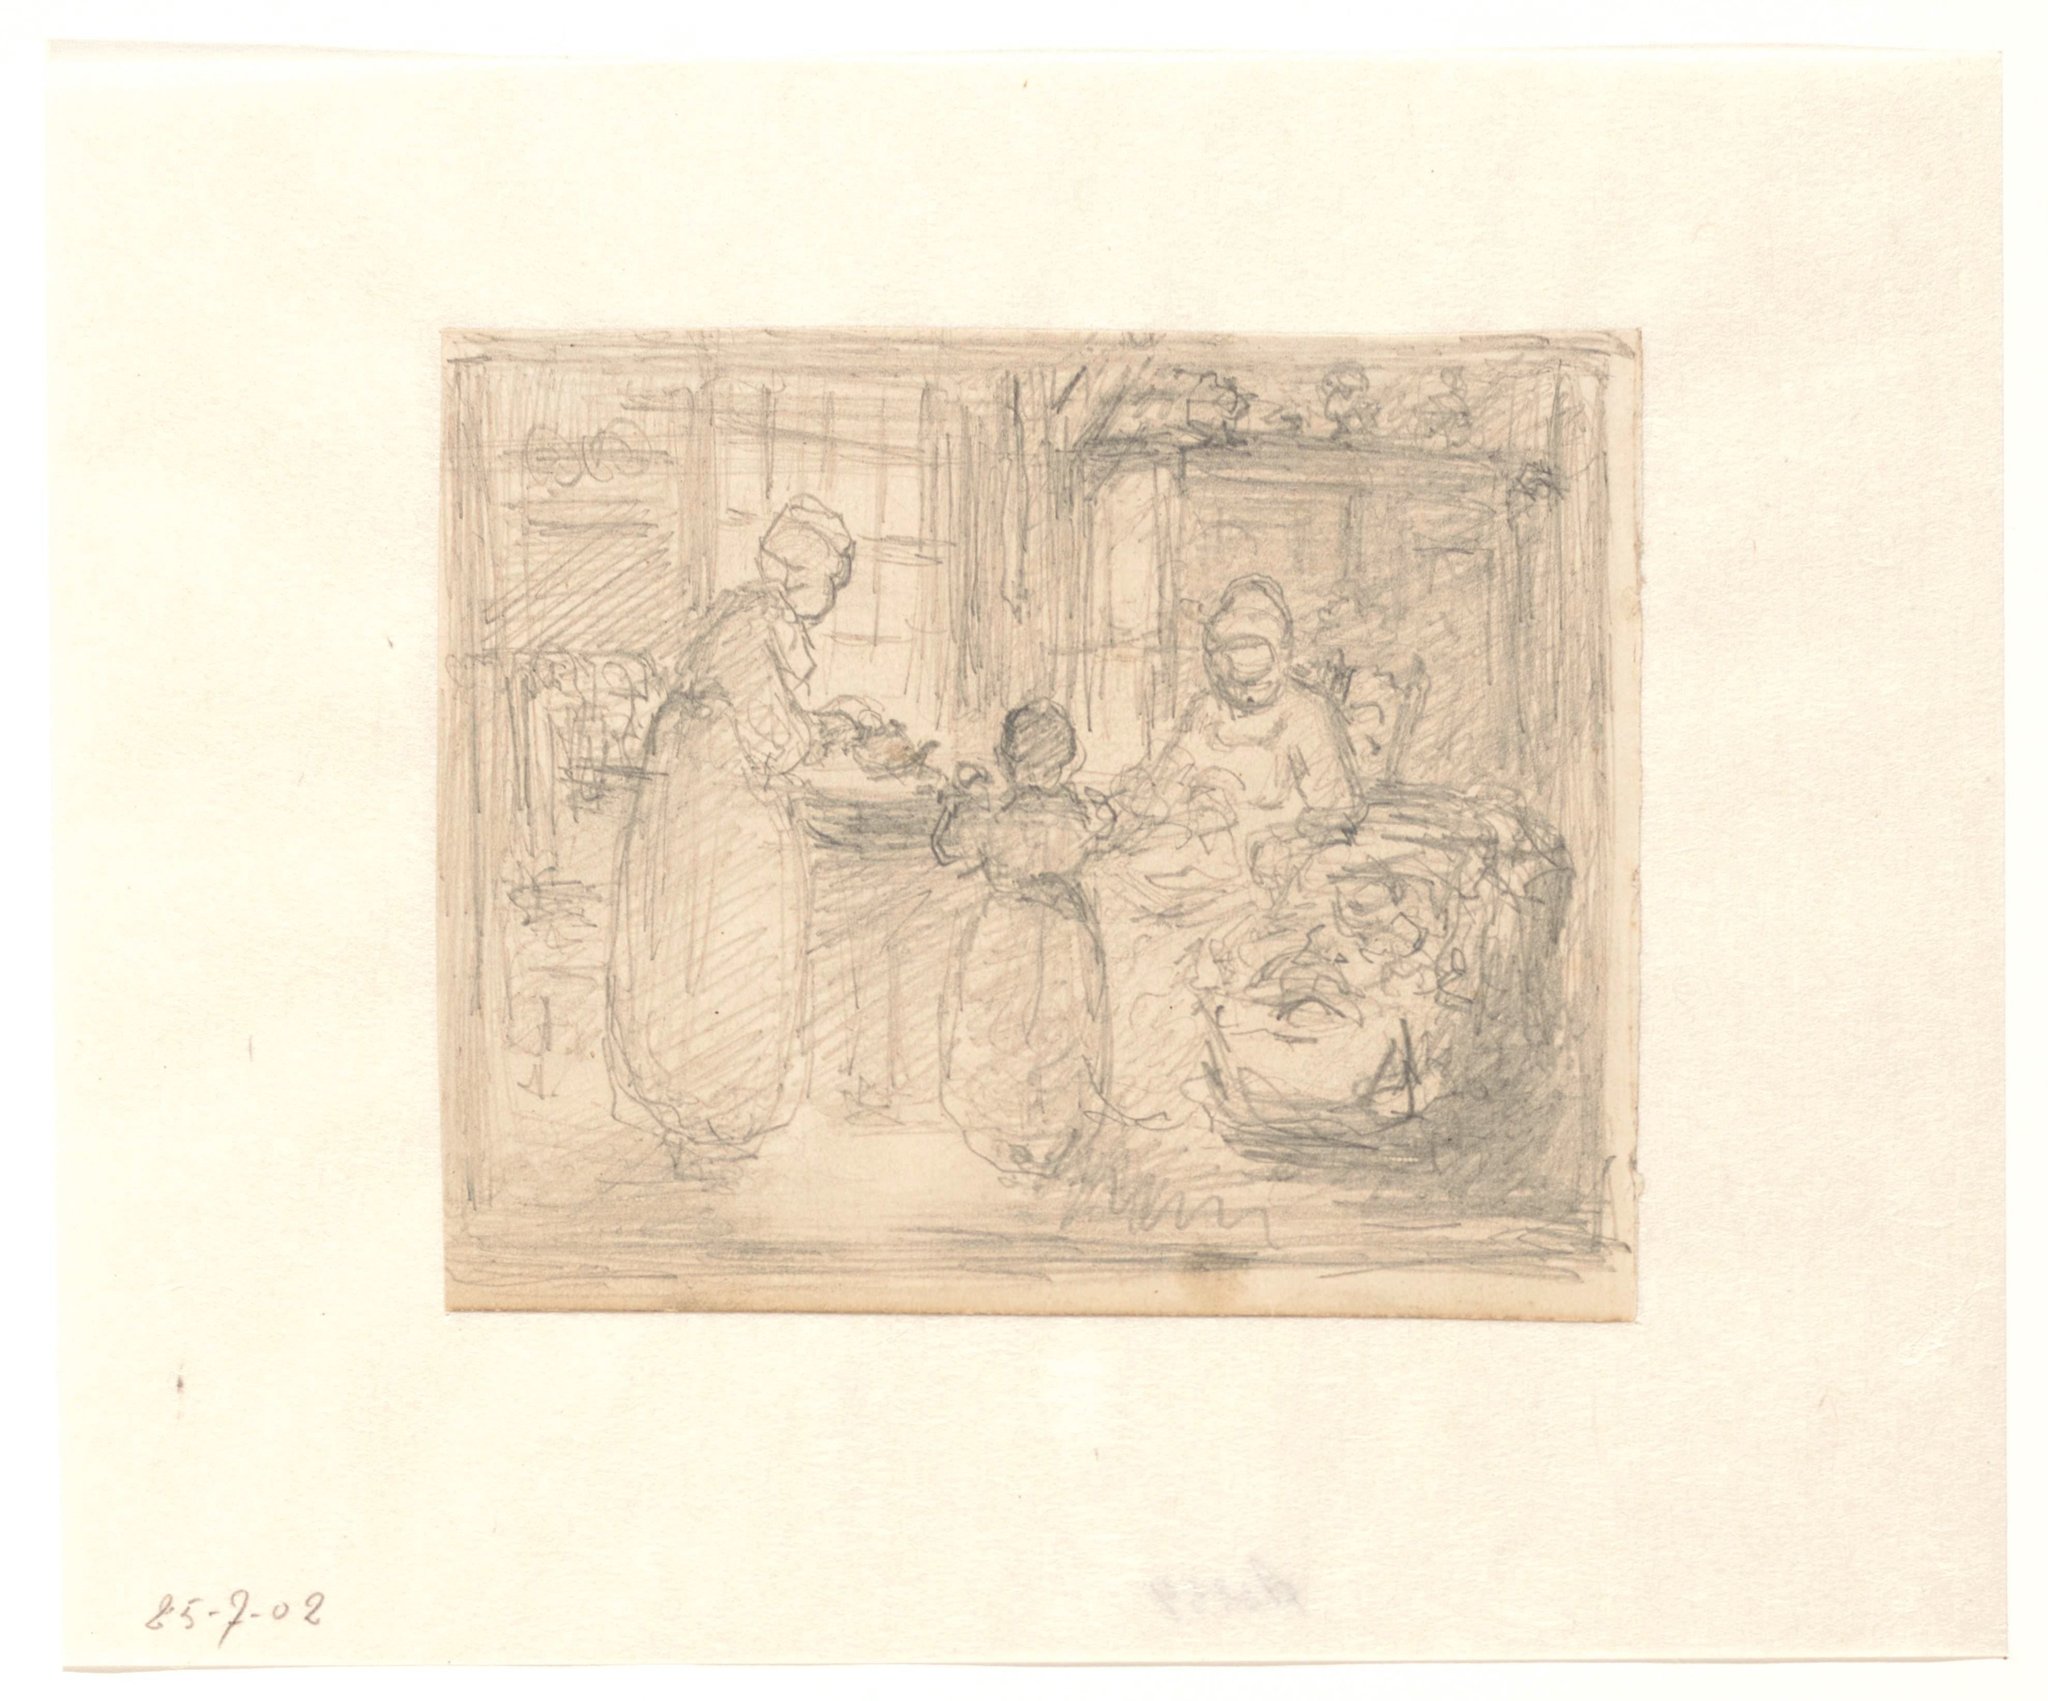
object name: drawing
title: Interieur met vrouwen en een wieg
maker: hendrik valkenburg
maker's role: draughtsman, painter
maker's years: 1826-1896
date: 1836-1896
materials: paper, pencil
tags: interior of the house, mother and child(ren), woman and child(ren) (family group)